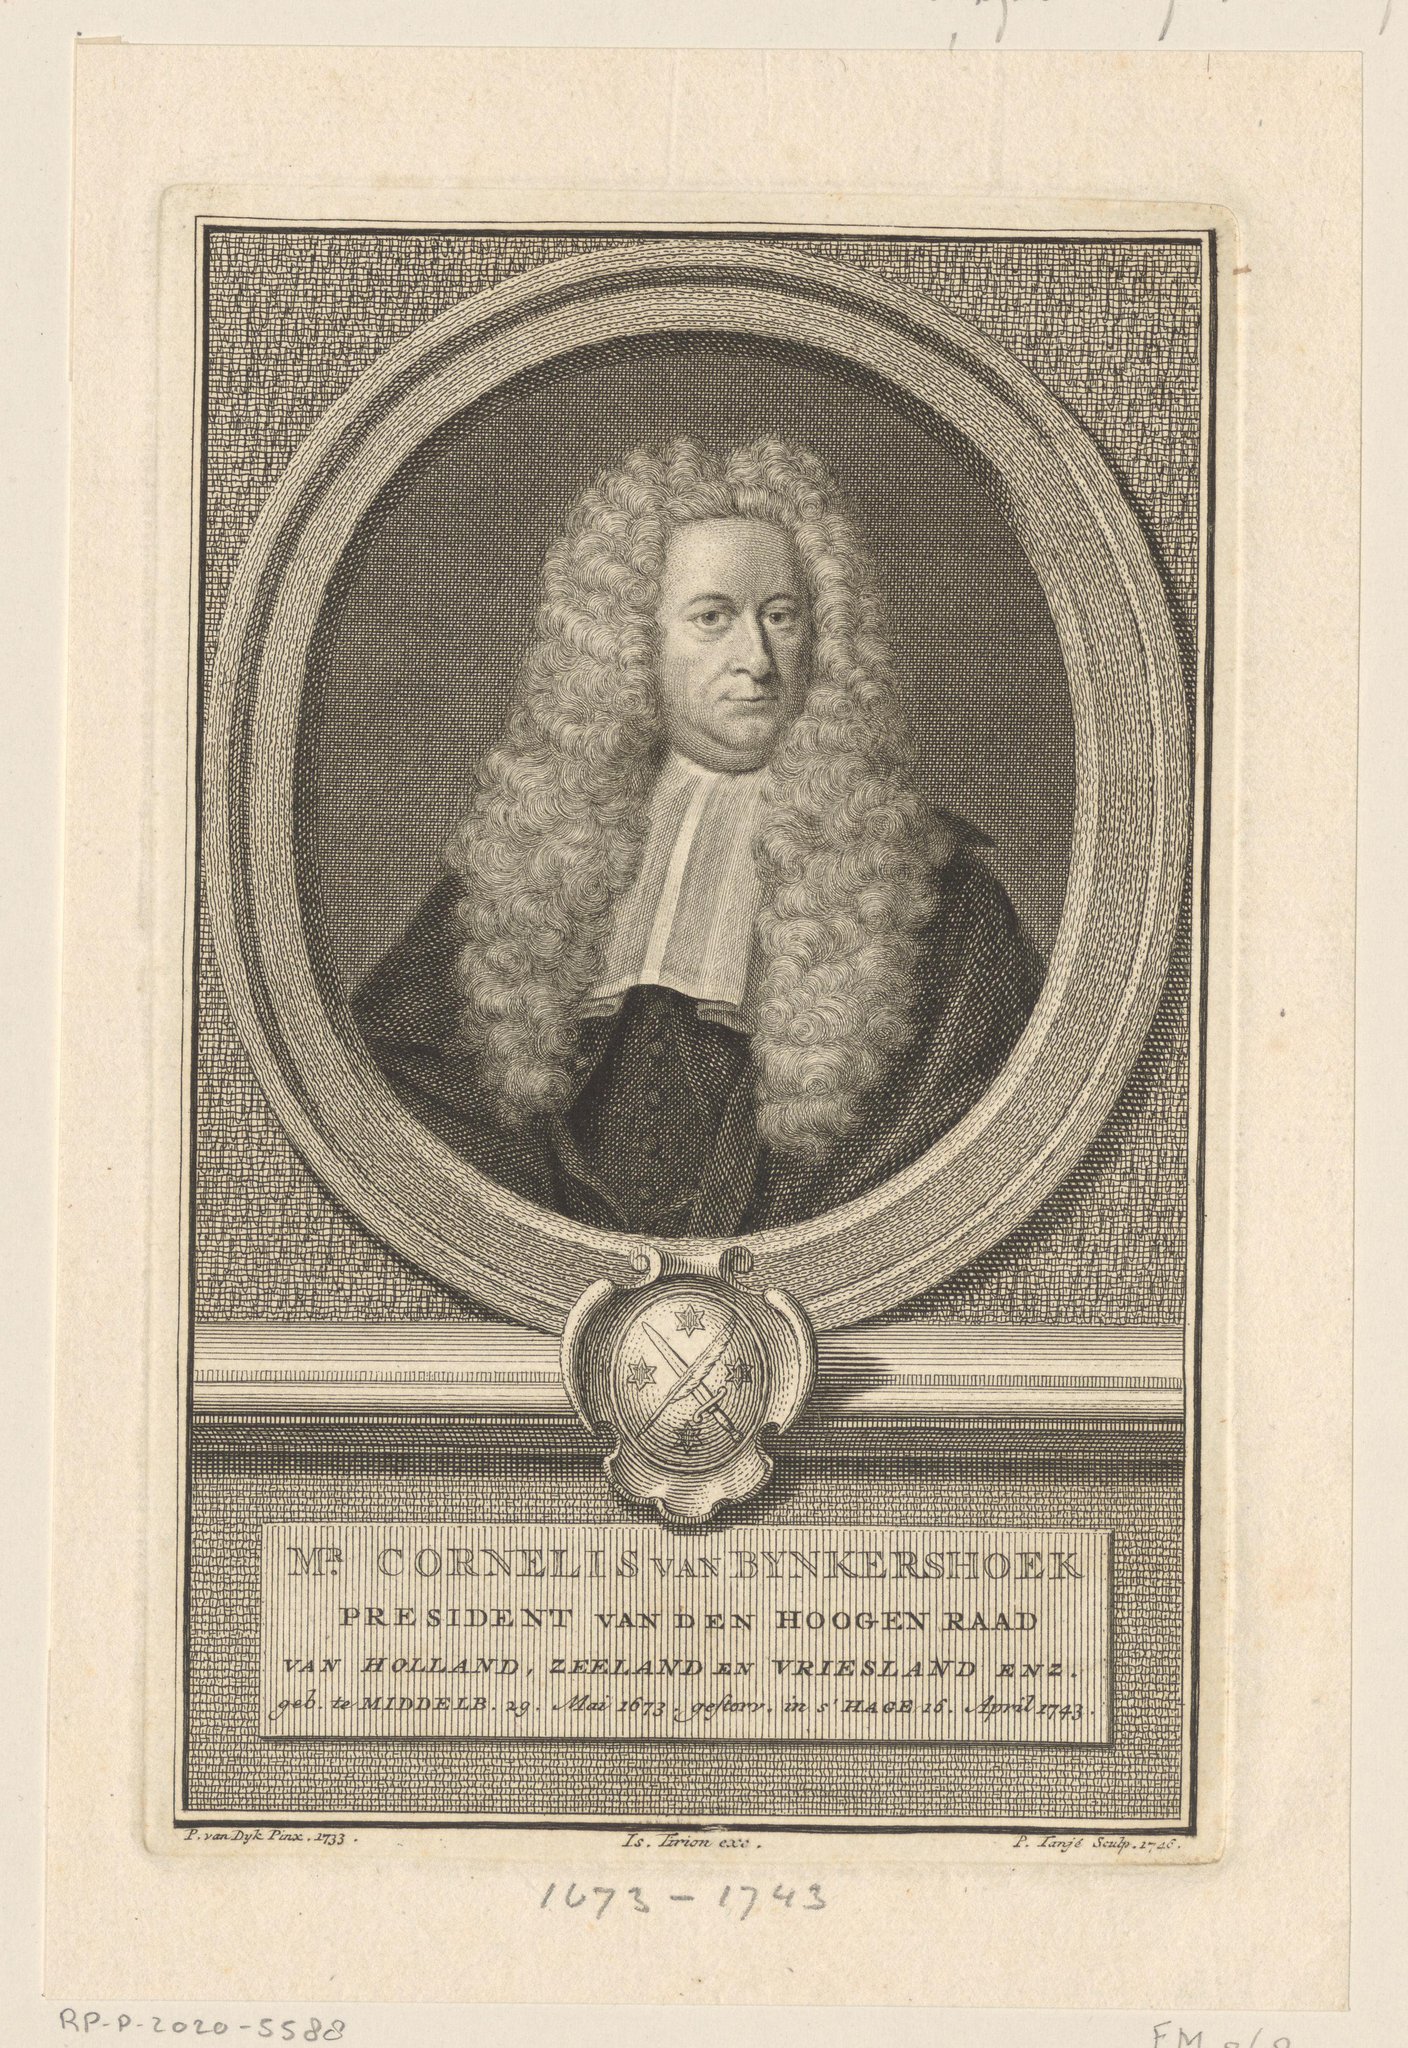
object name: print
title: Portret van Cornelis van Bynkershoek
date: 1746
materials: paper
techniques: engraving, etching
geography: amsterdam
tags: historical persons, lawyer, attorney at law, armorial bearing, heraldry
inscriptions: date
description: Prent gebruikt in: Atlas van Zeeland; vervattende naauwkeurige kaarten van alle de eilanden, (...). Amsterdam: Isaak Tirion, 1660.